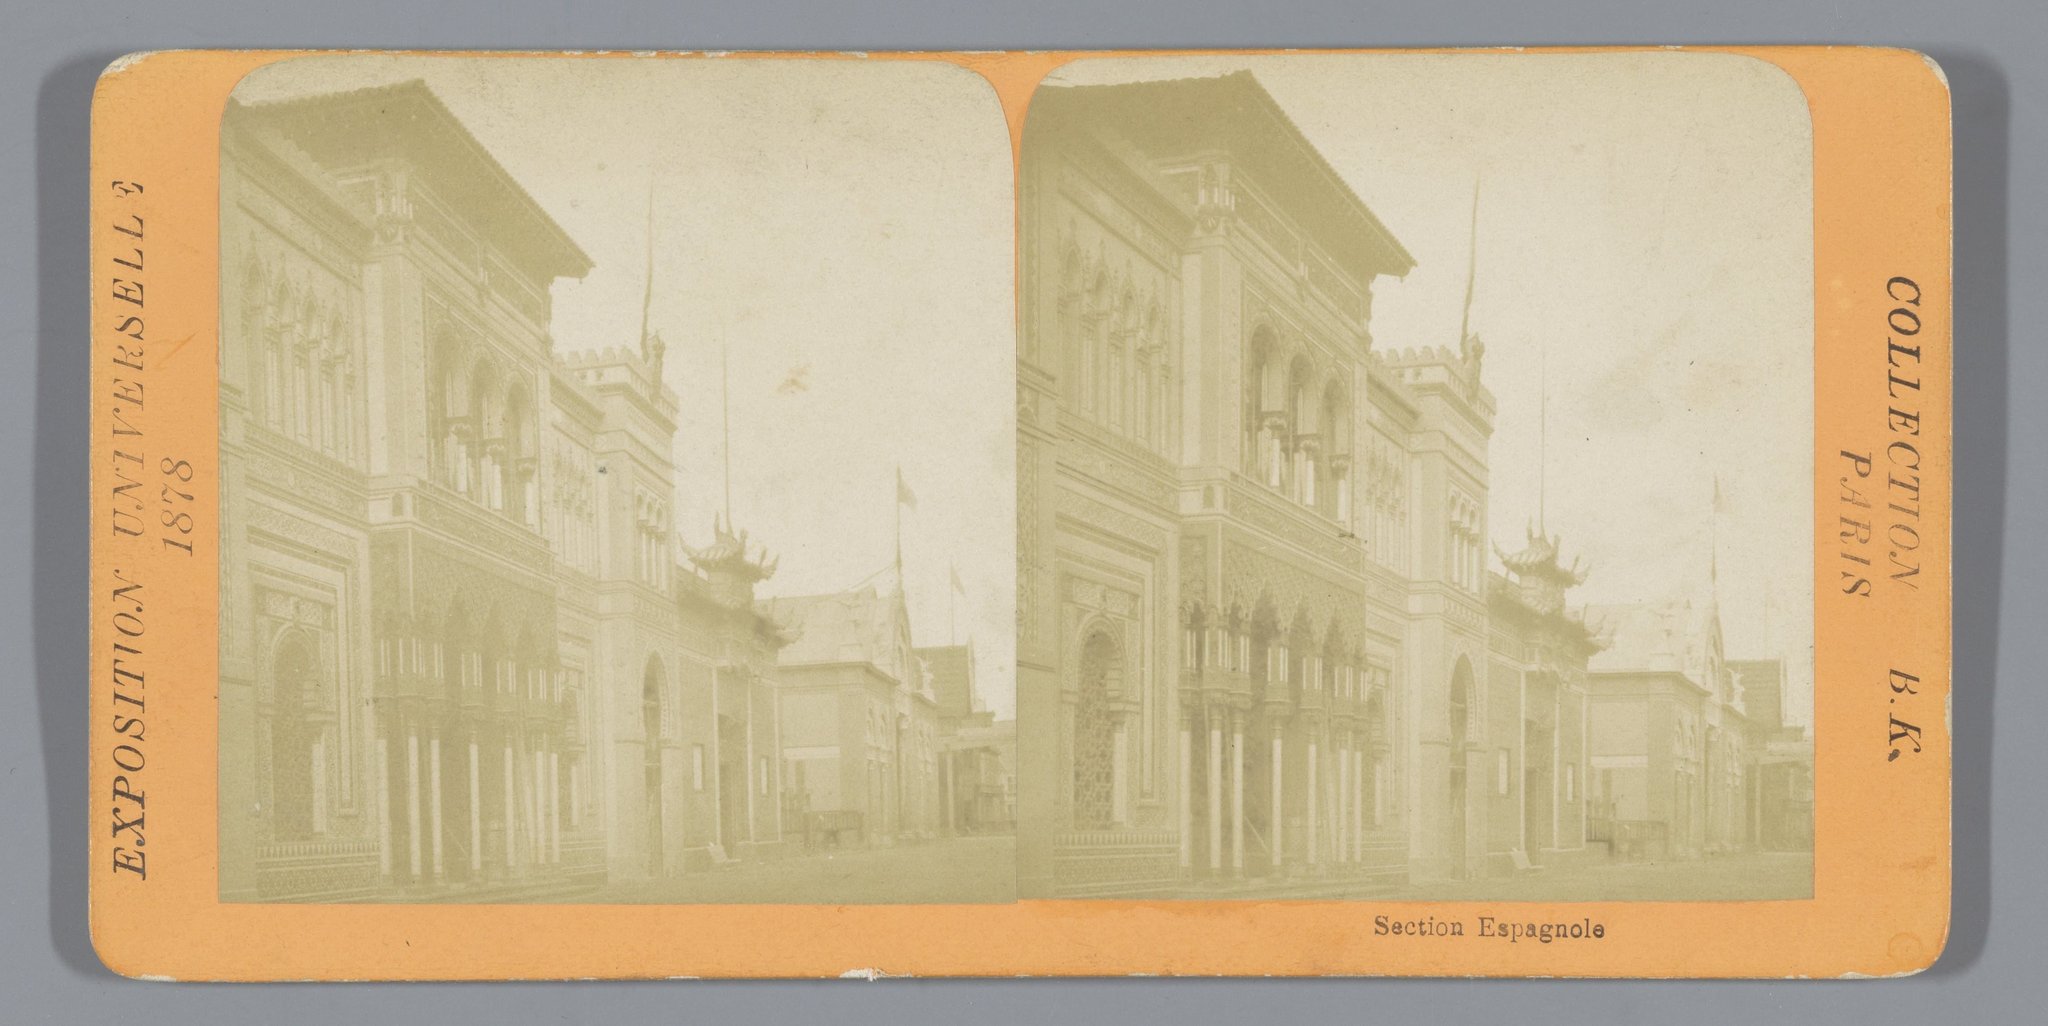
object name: stereograph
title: Exposition Universelle 1878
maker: adolphe block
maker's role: publisher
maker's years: 1829-1918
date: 1878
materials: cardboard, paper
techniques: albumen print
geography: paris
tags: world fair, world exhibition, exterior ~ representation of a building, paris